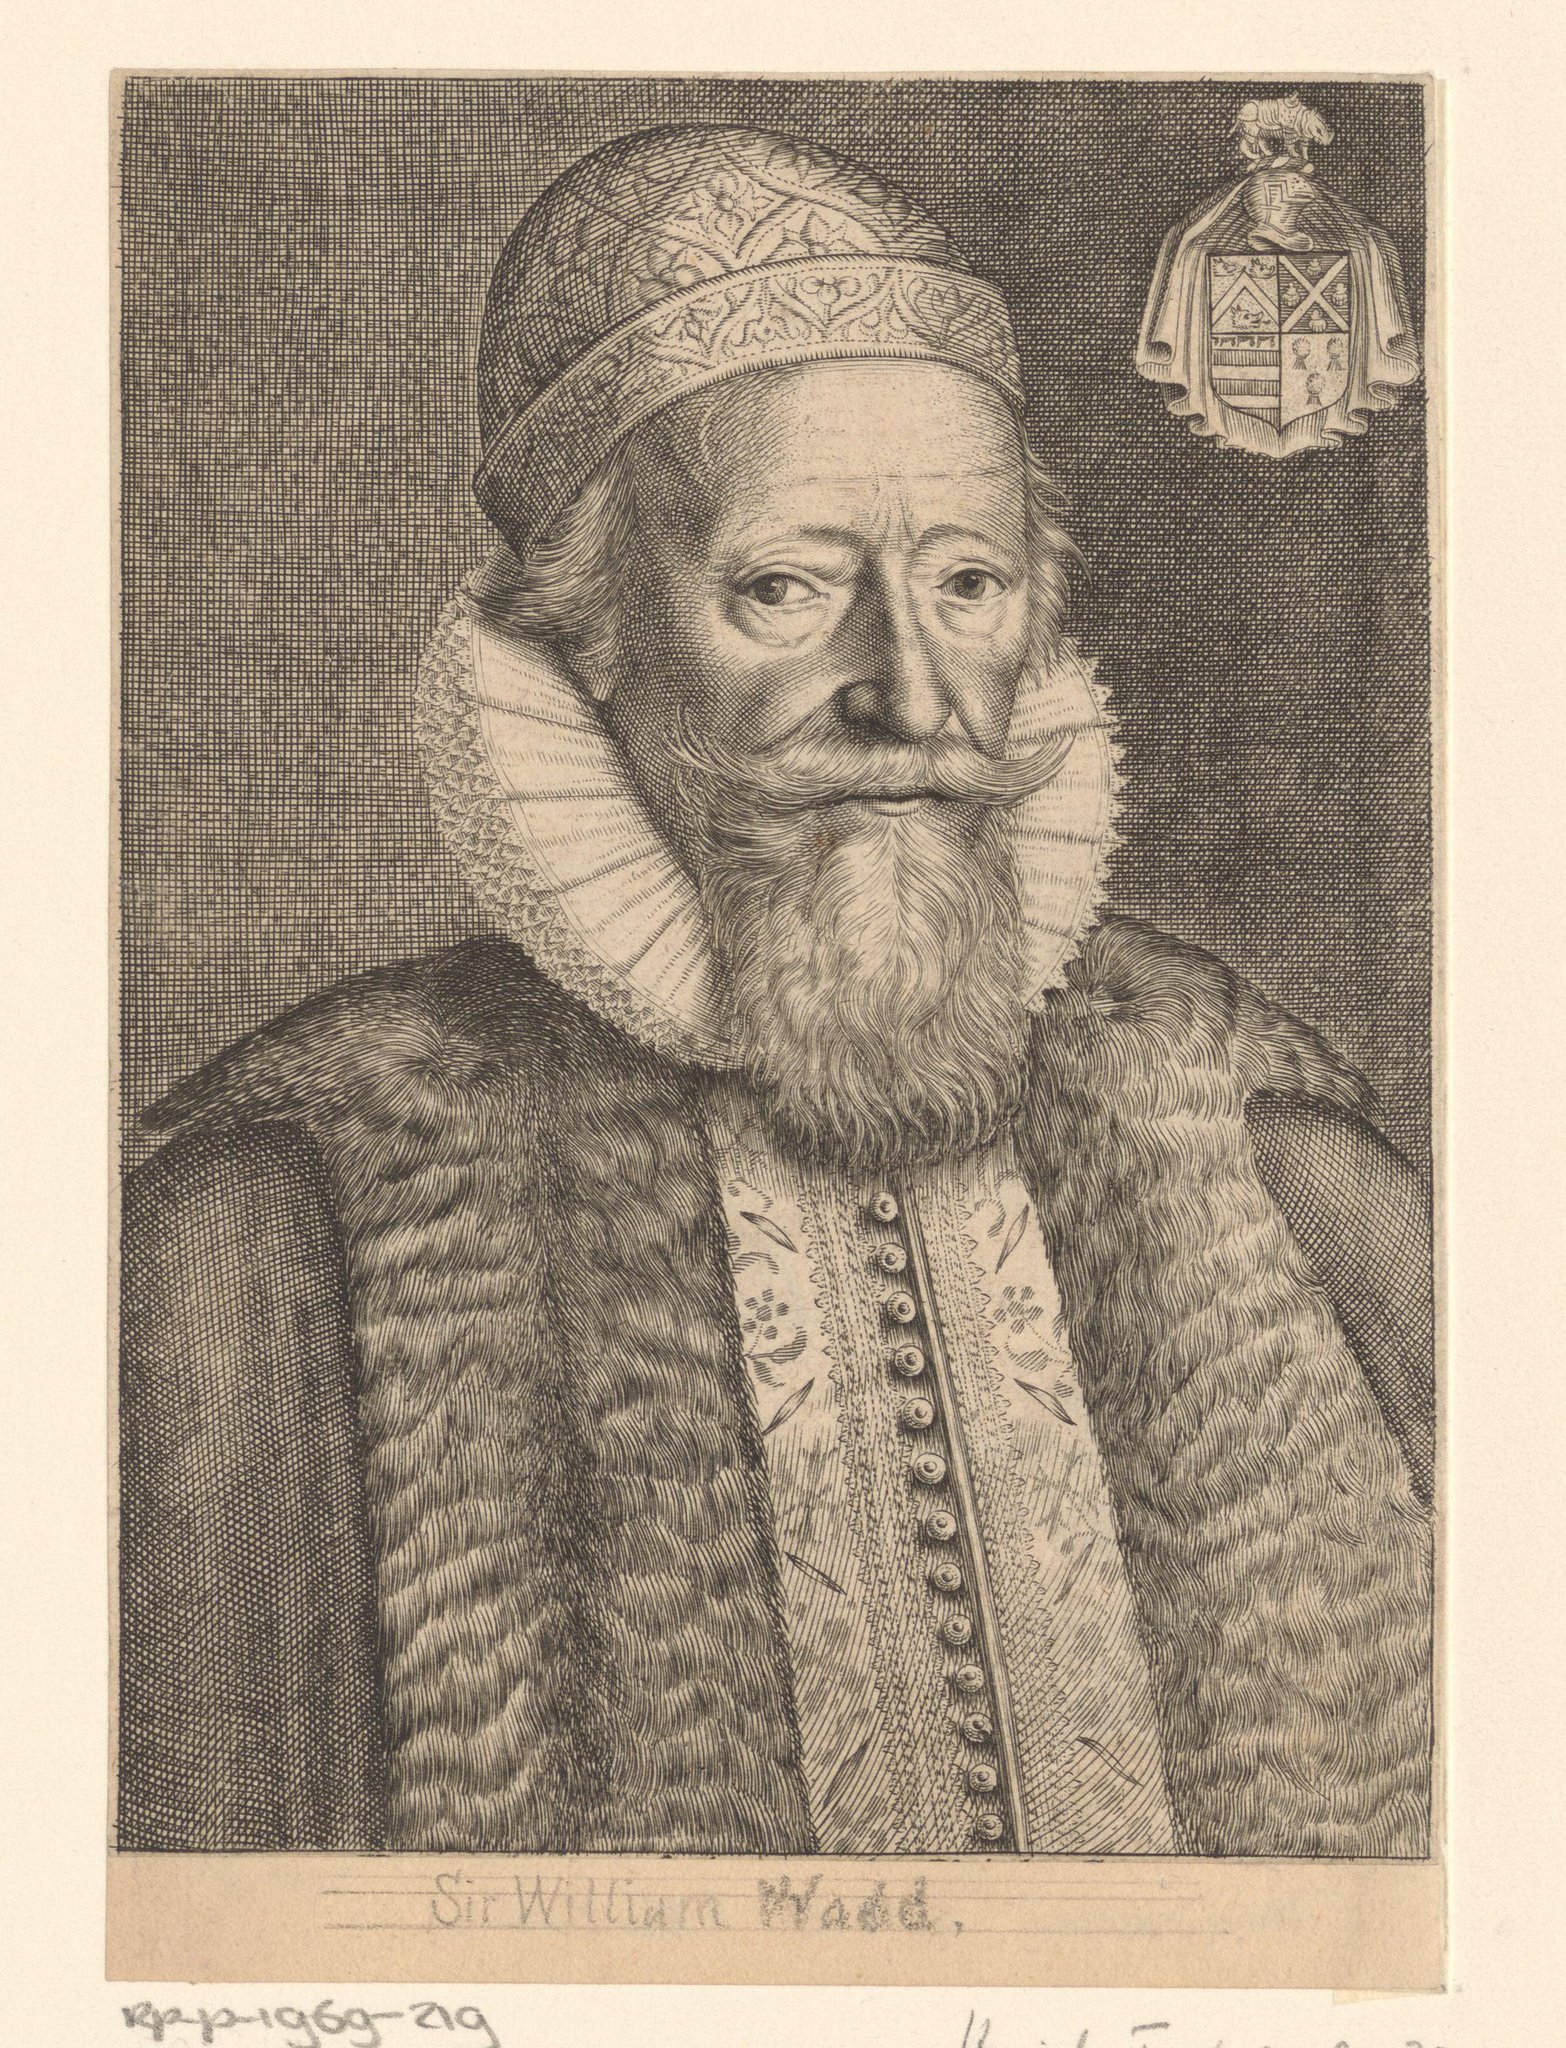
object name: print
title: Portret van William Wade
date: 1623-1648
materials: paper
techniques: engraving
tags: politician, historical persons, politician, e.g. party leader, armorial bearing, heraldry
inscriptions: collector's mark: Lugt 2228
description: Prent ook gebruikt in: Granger, James. A Biographical History of England, from Herbert the Great to the Revolution (...). Londen: William Baynes & Son, 1824, dl. 2.